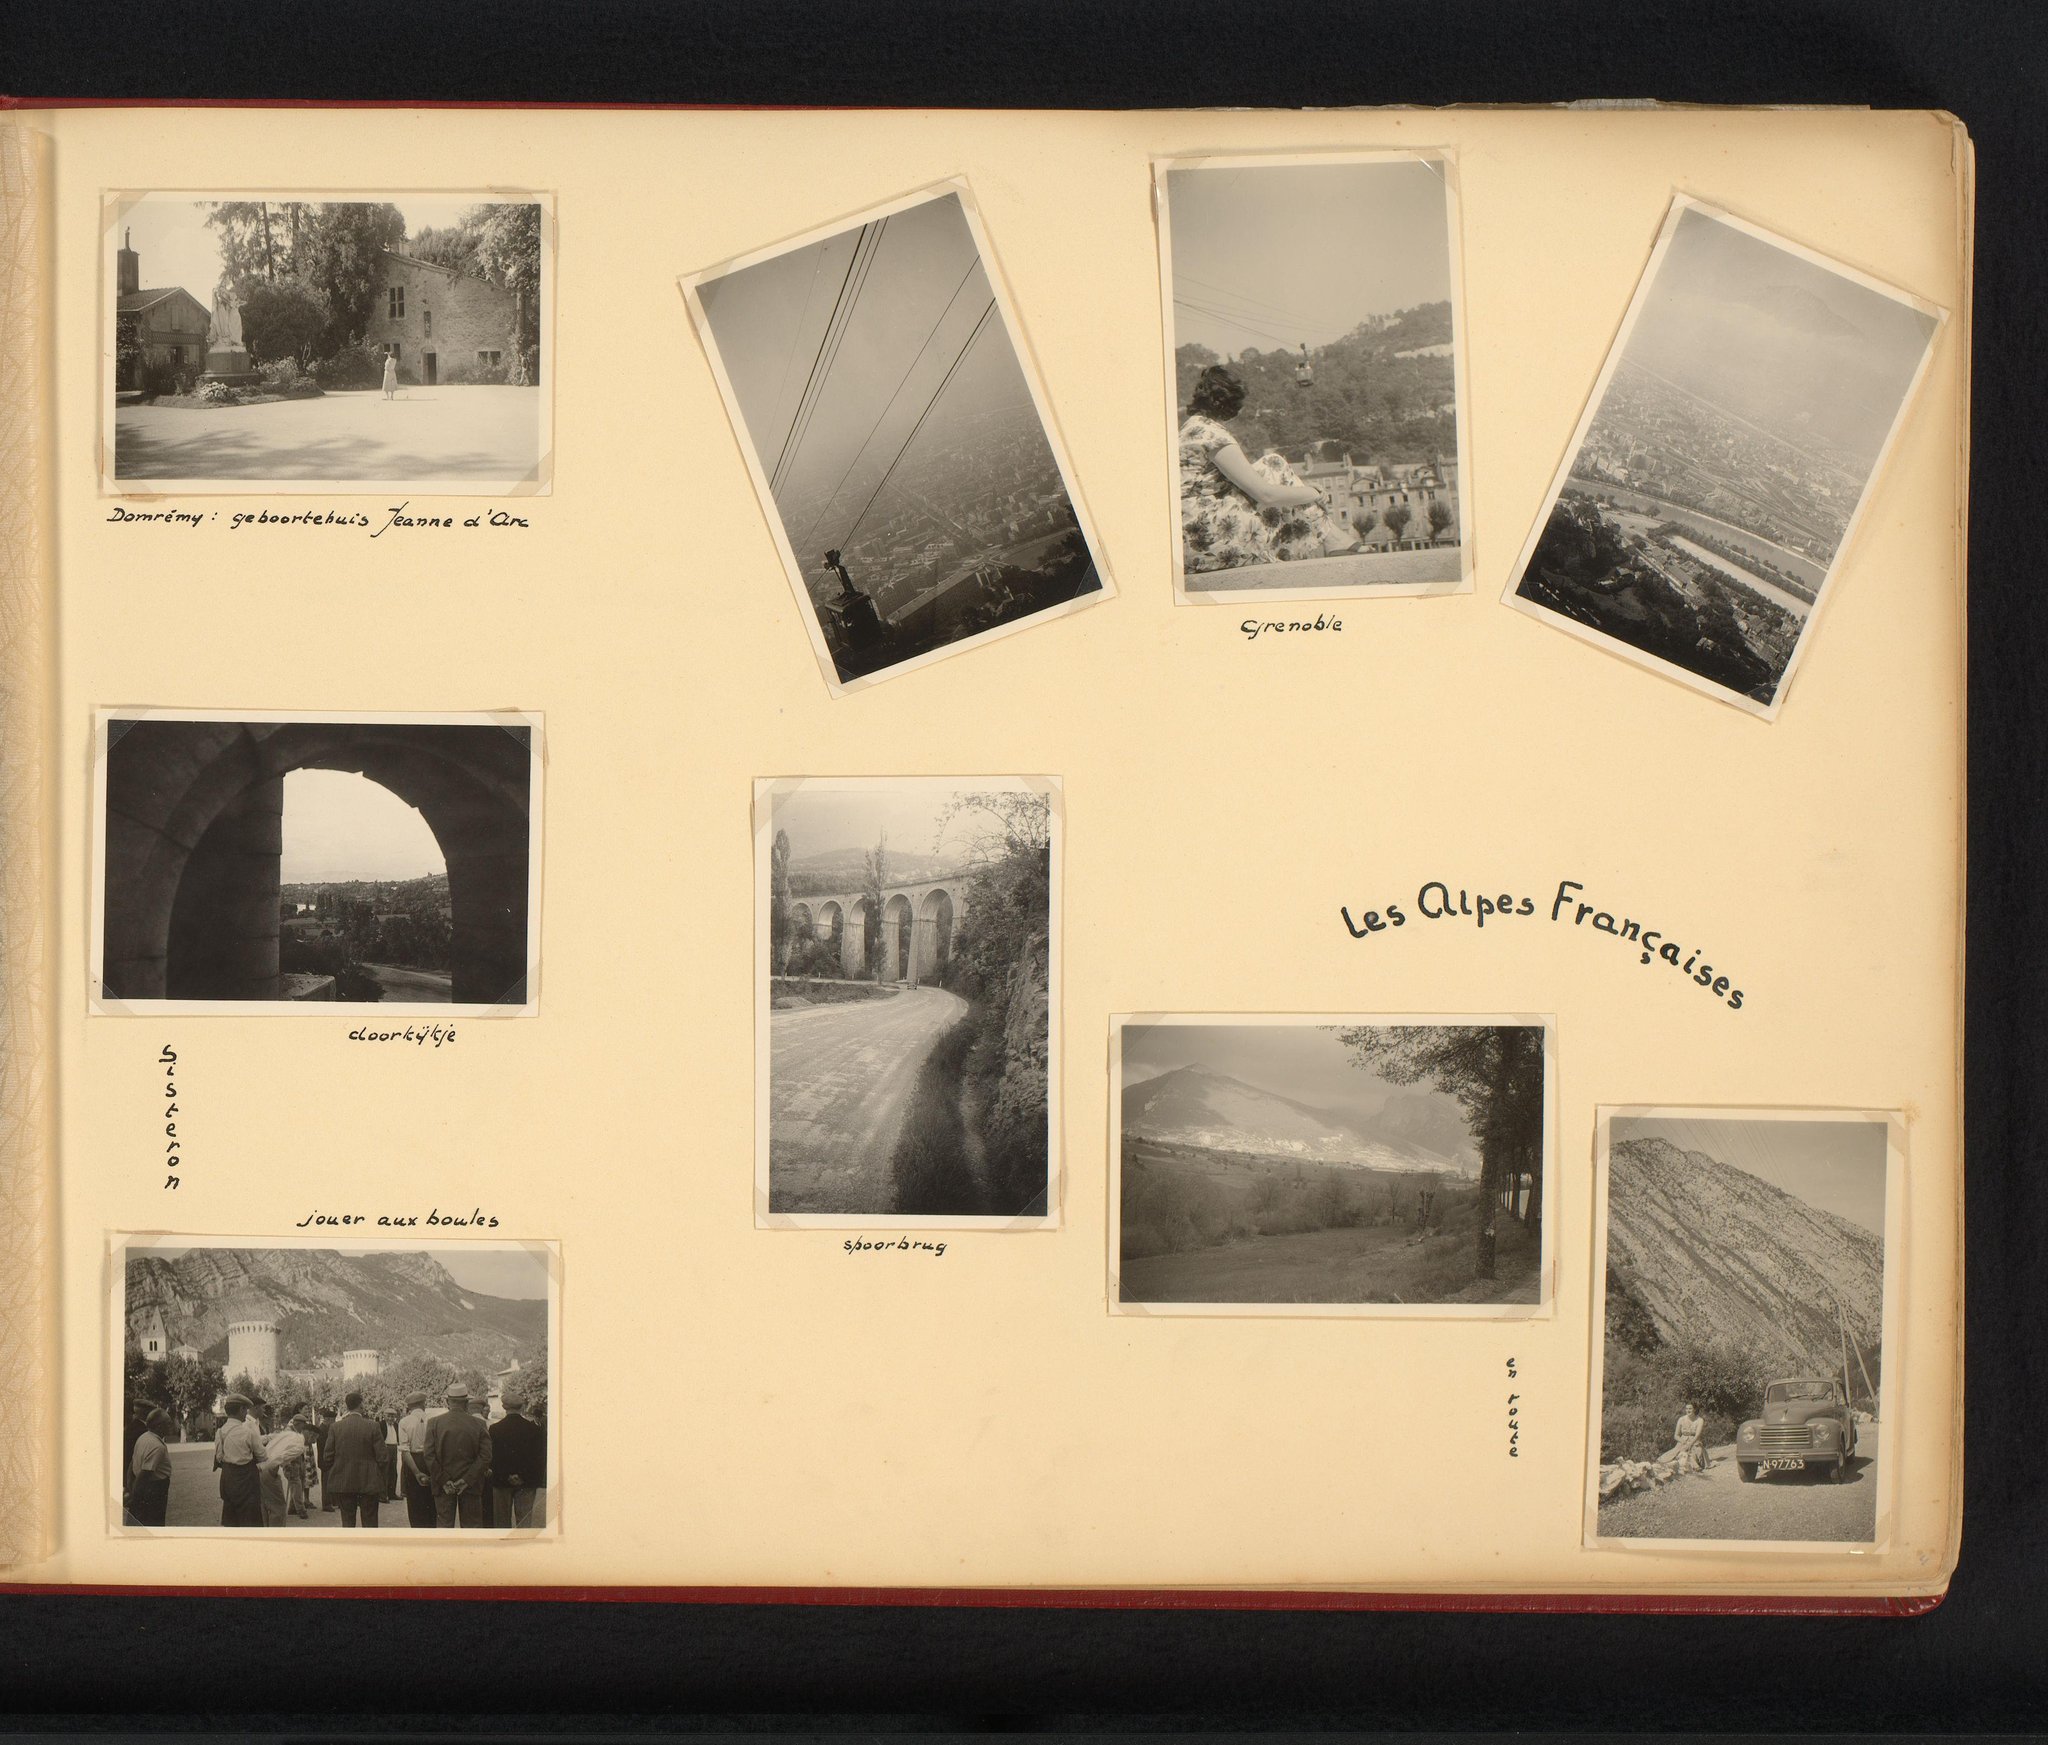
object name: photograph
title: Les Alpes Françaises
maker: Anonymous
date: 1951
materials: paper, photographic support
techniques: gelatin silver print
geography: france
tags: the family travelling, on holiday, outing, pleasure trip, mountain-range, snow peaks, automobile, france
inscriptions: inscription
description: Albumblad met negen foto's onderweg in de Franse Alpen. Herinnering aan een vakantiereis door Frankrijk van 23 augustus tot 9 september 1951. Onderdeel van het fotoalbum 'Met de Fiat 500 cabriolet op vakantie' met foto's van vakanties van een gezin tussen 1951-1959.